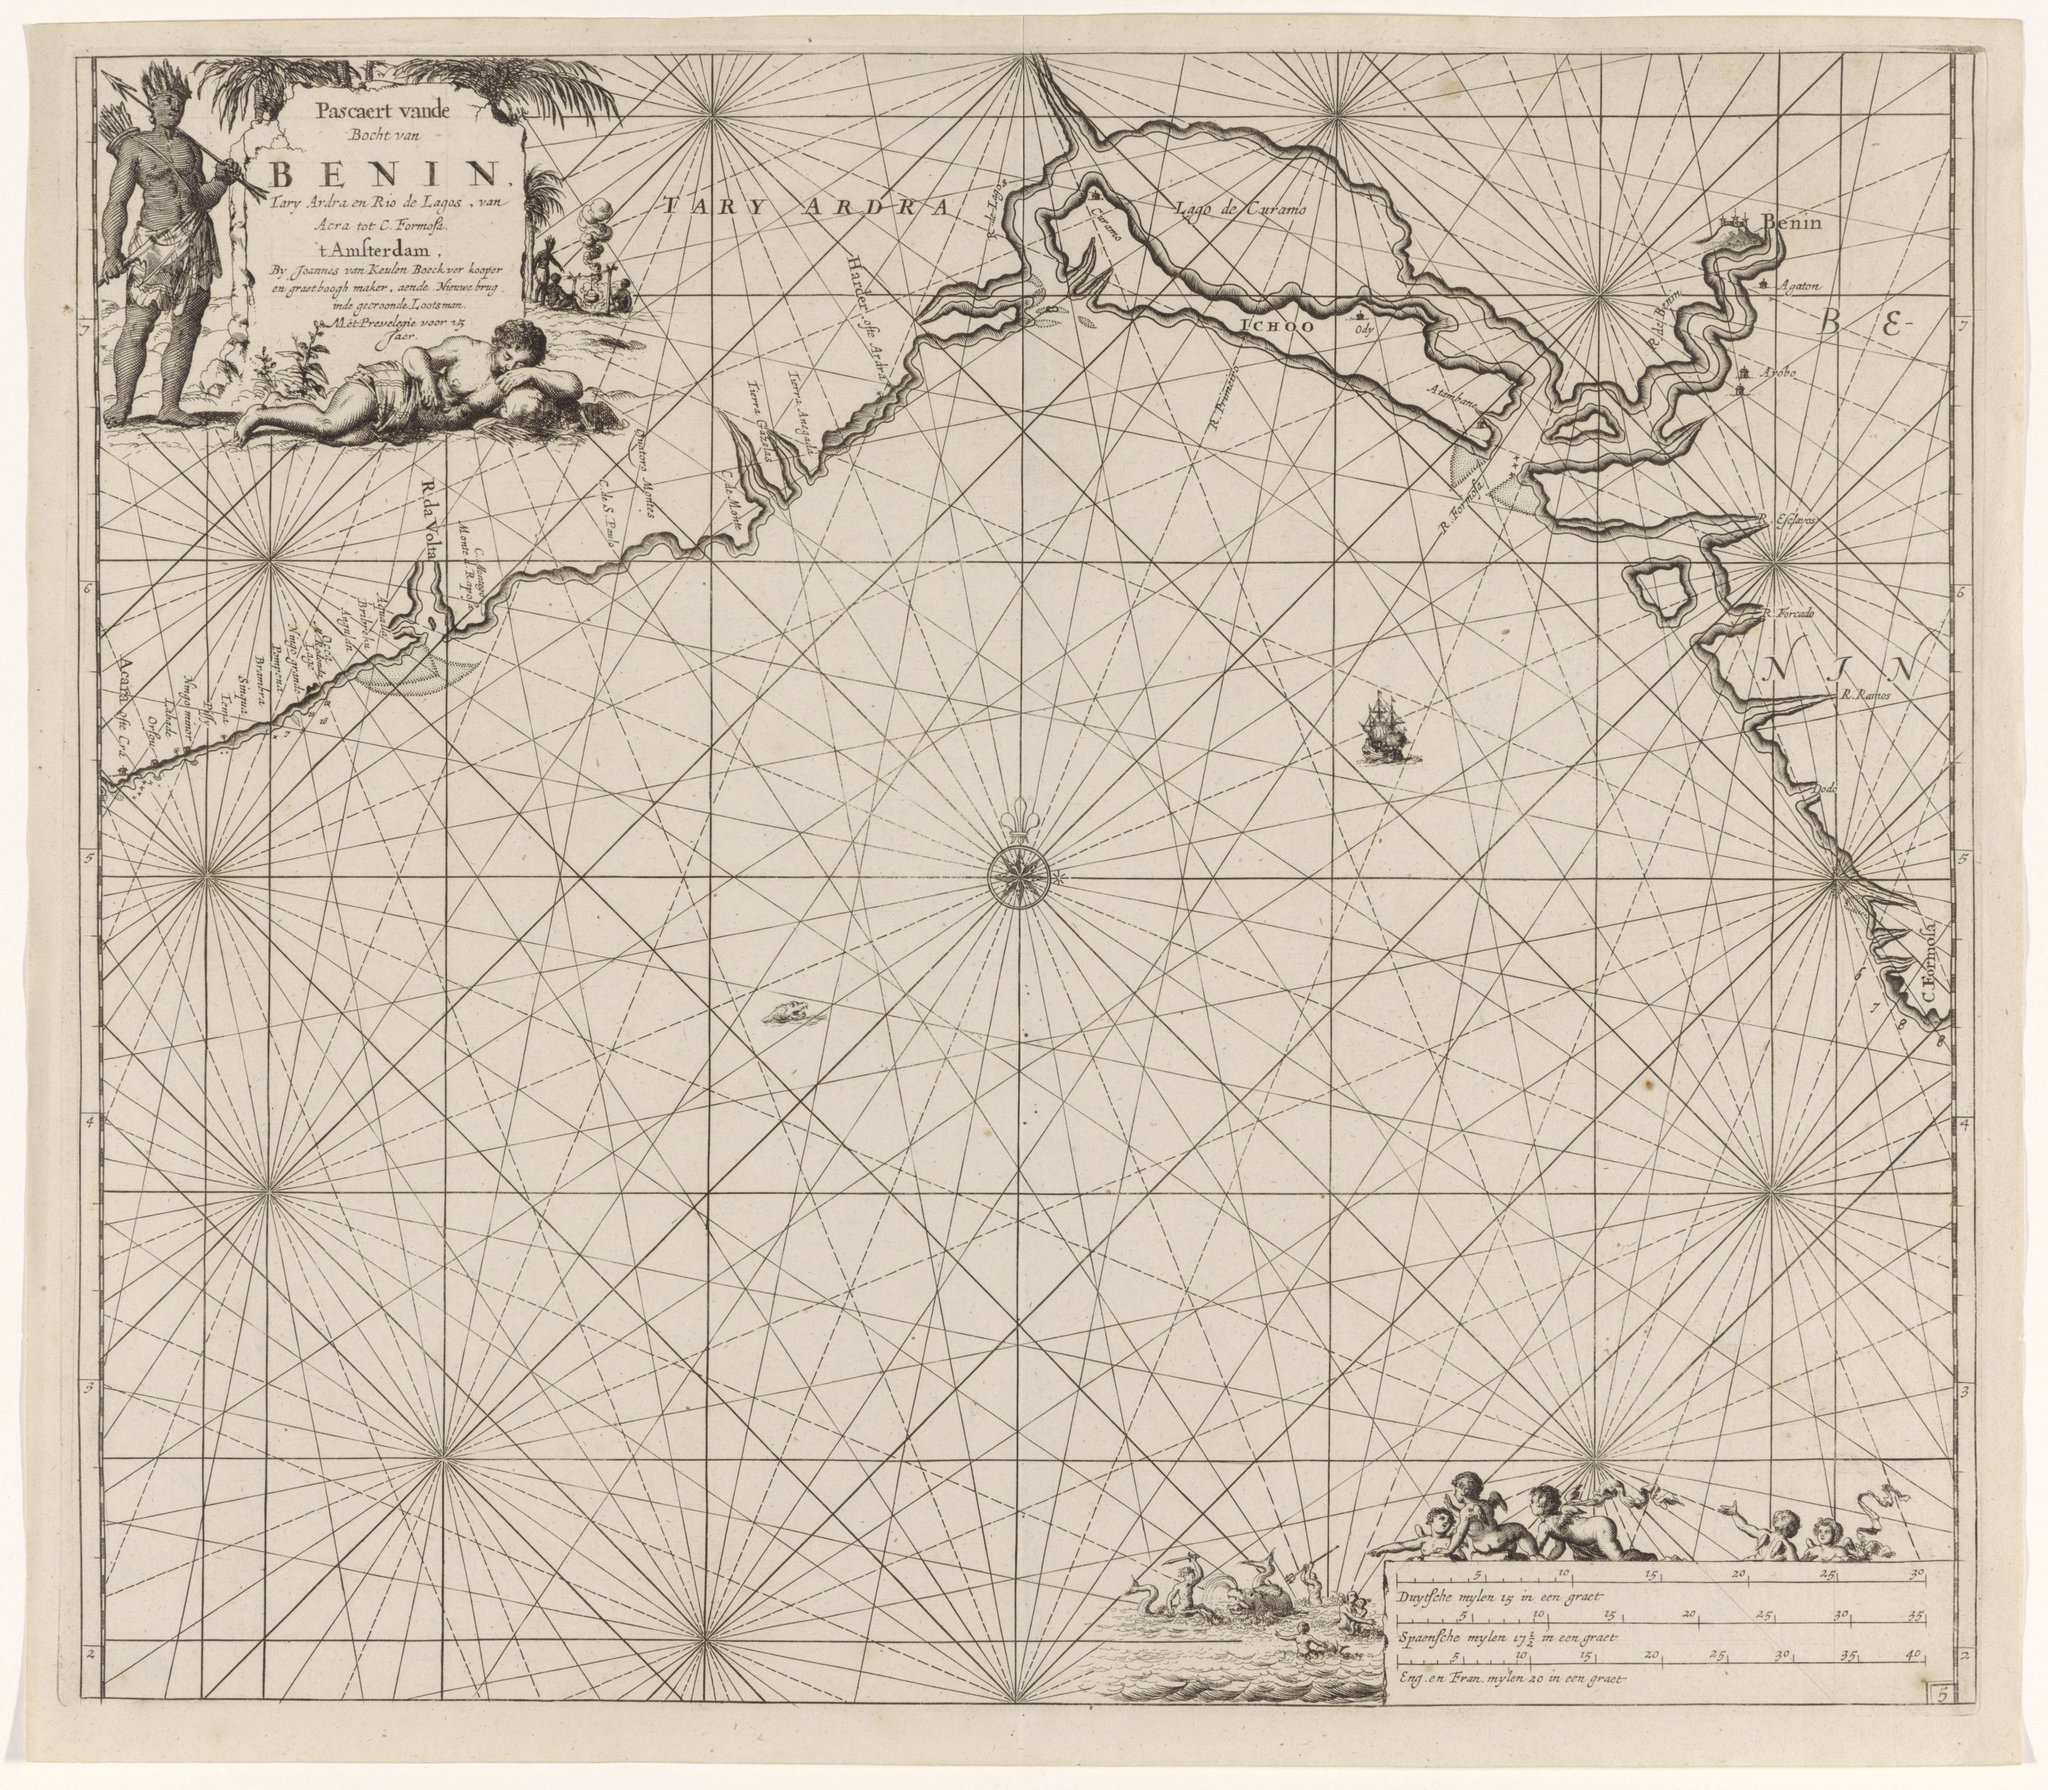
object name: print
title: Paskaart van de Golf van Benin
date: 1683-1799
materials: paper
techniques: engraving, etching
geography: amsterdam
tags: sailing-ship, sailing-boat, archer's weapons: bow and arrow, merman, africans, sleeping on the ground, cupids: 'amores', 'amoretti', 'putti', swimming mammals: whale, atlantic ocean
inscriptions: collector's mark: Lugt 2228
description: Paskaart van de Golf van Benin aan de westkust van Afrika, met een kompasroos, het Noorden ligt boven. Linksboven de titel en het adres van de uitgever, omgeven door een donkere man met pijl en boog en verentooi, een slapende man en een groep mannen bij een kampvuur. Rechtsonder enkele putti en meermannen bij de schaalverdeling, welke is weergegeven in Duitse, Spaanse en Engelse of Franse mijlen (schaal: c. 1:1.400.000).